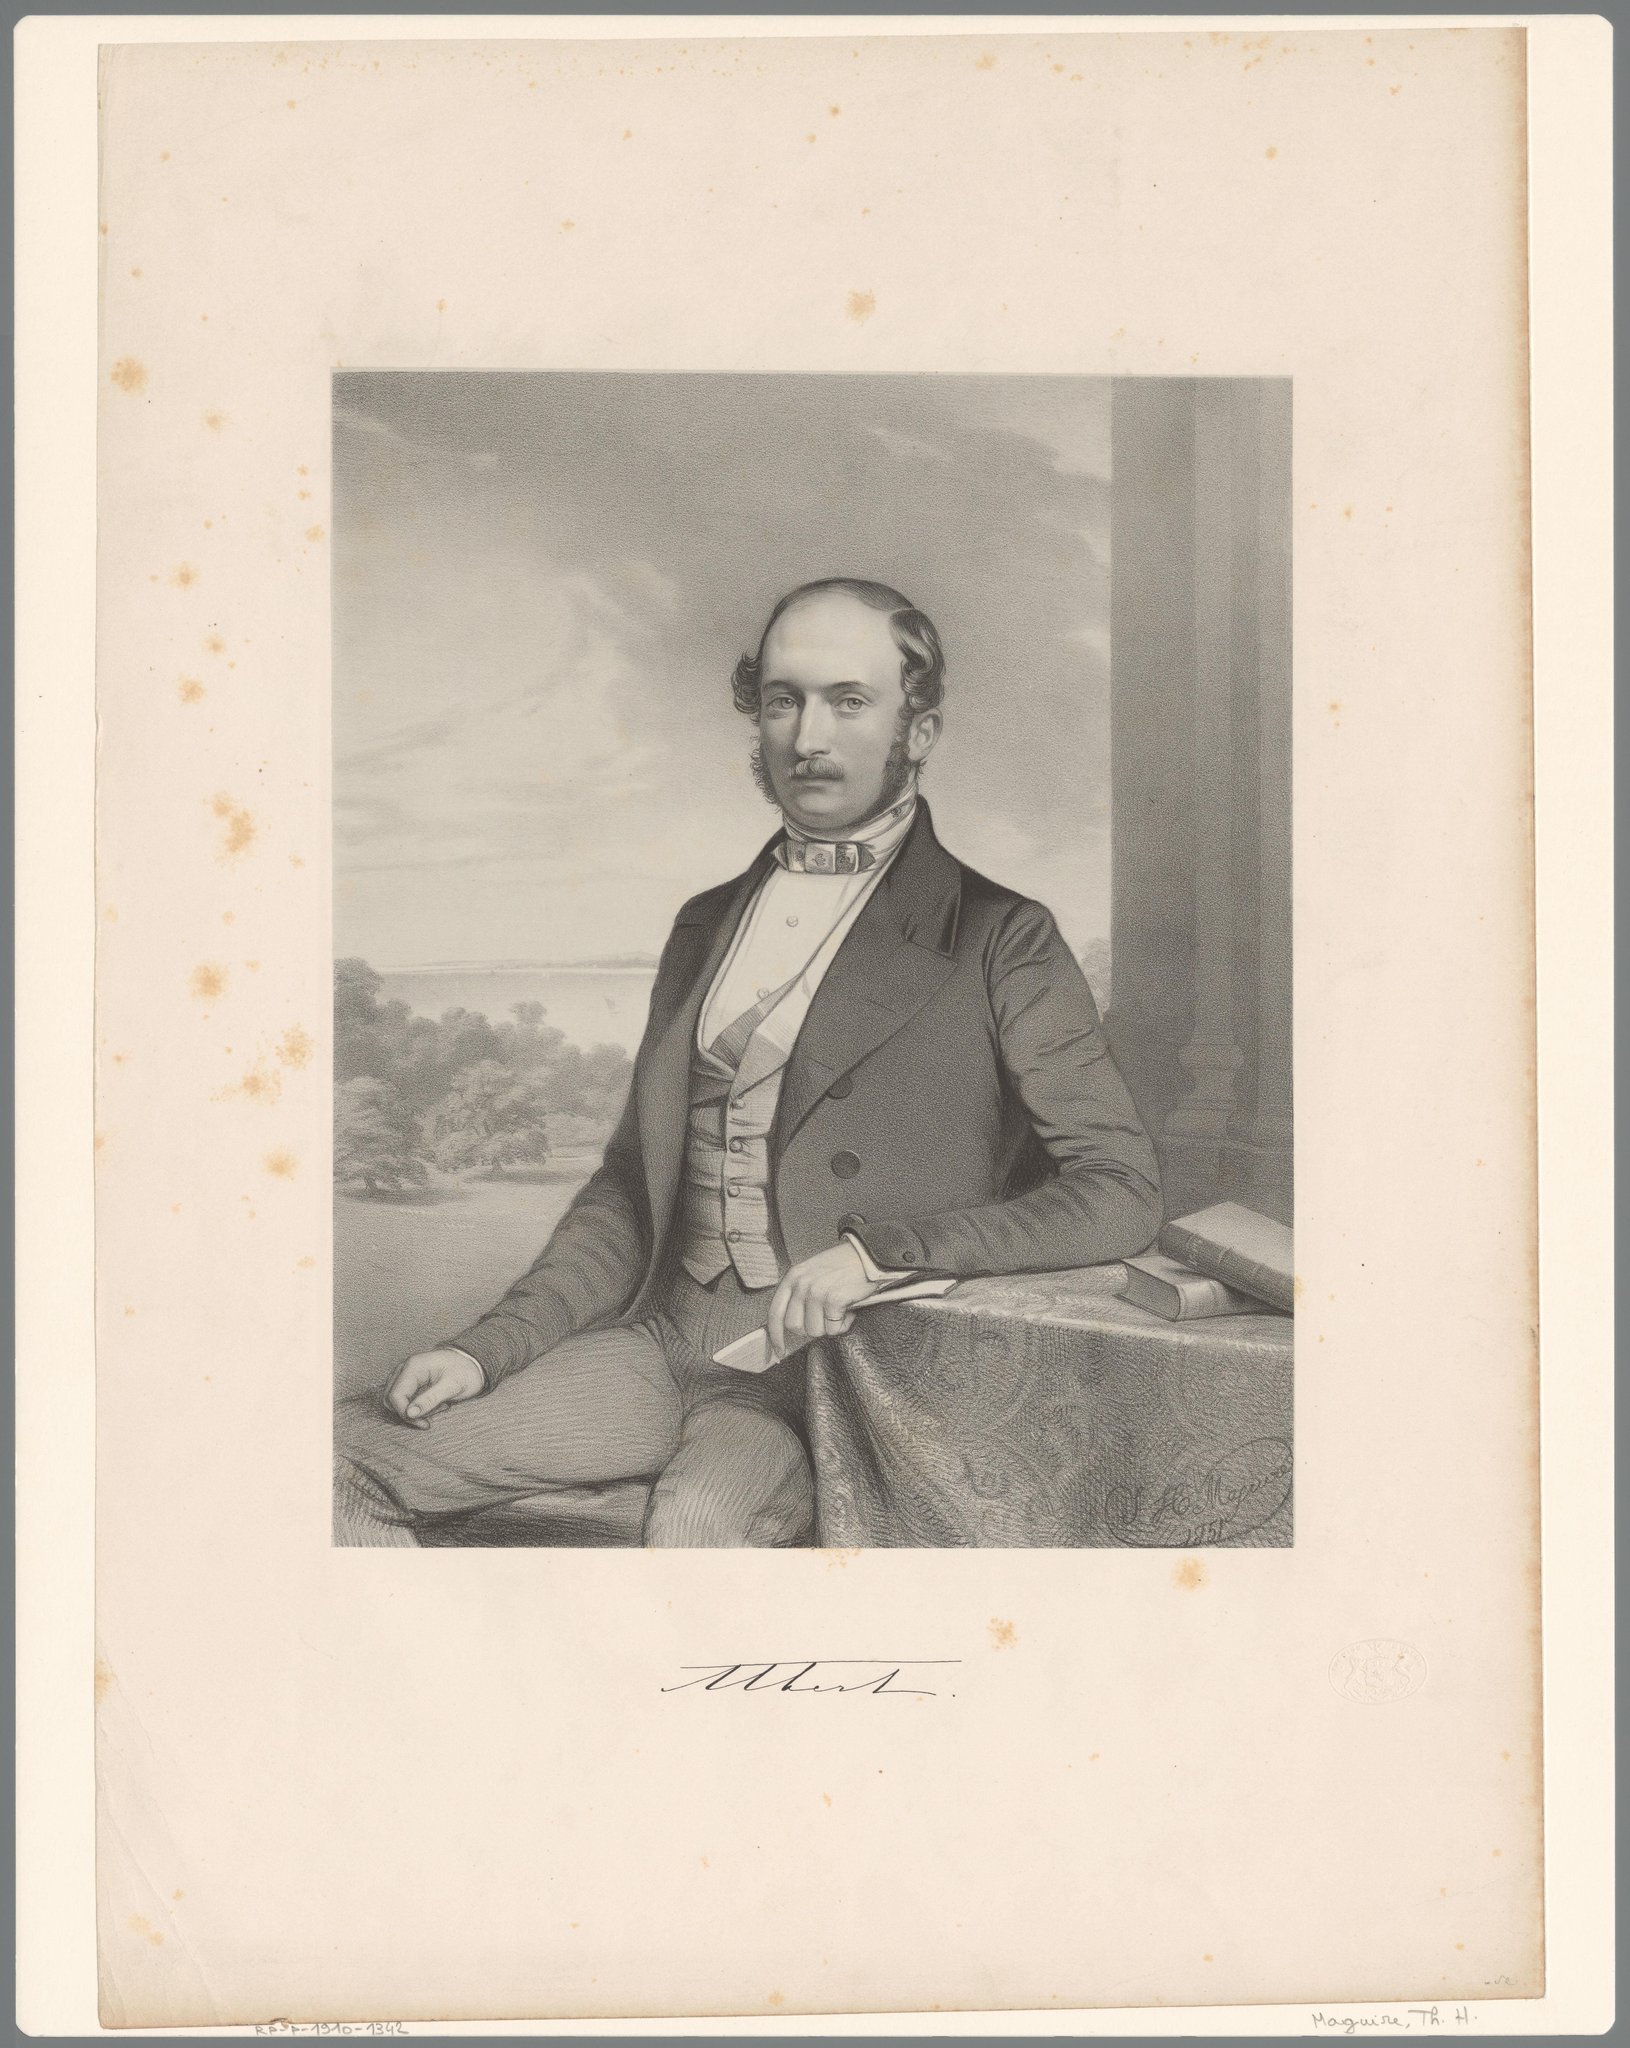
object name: print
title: Ipswich Museum Portraits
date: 1852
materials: paper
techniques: lithograph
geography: london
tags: albert (prins van saksen-coburg en gotha), moustache, adult man, historical persons, table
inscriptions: check stamp: ‘Ipswich Museum’, collector's mark: Lugt 2228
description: Prent behoort tot de serie 'Ipswich Museum Portraits', ook bekend onder de titel 'Portraits of Honorary Members of the Ipswich Museum'. Deze serie is in 1852 door George Ransome uitgegeven en gedrukt door M&N Hanhart tussen 1848 en 1852. De serie bestaat uit ca. 60 portretten.